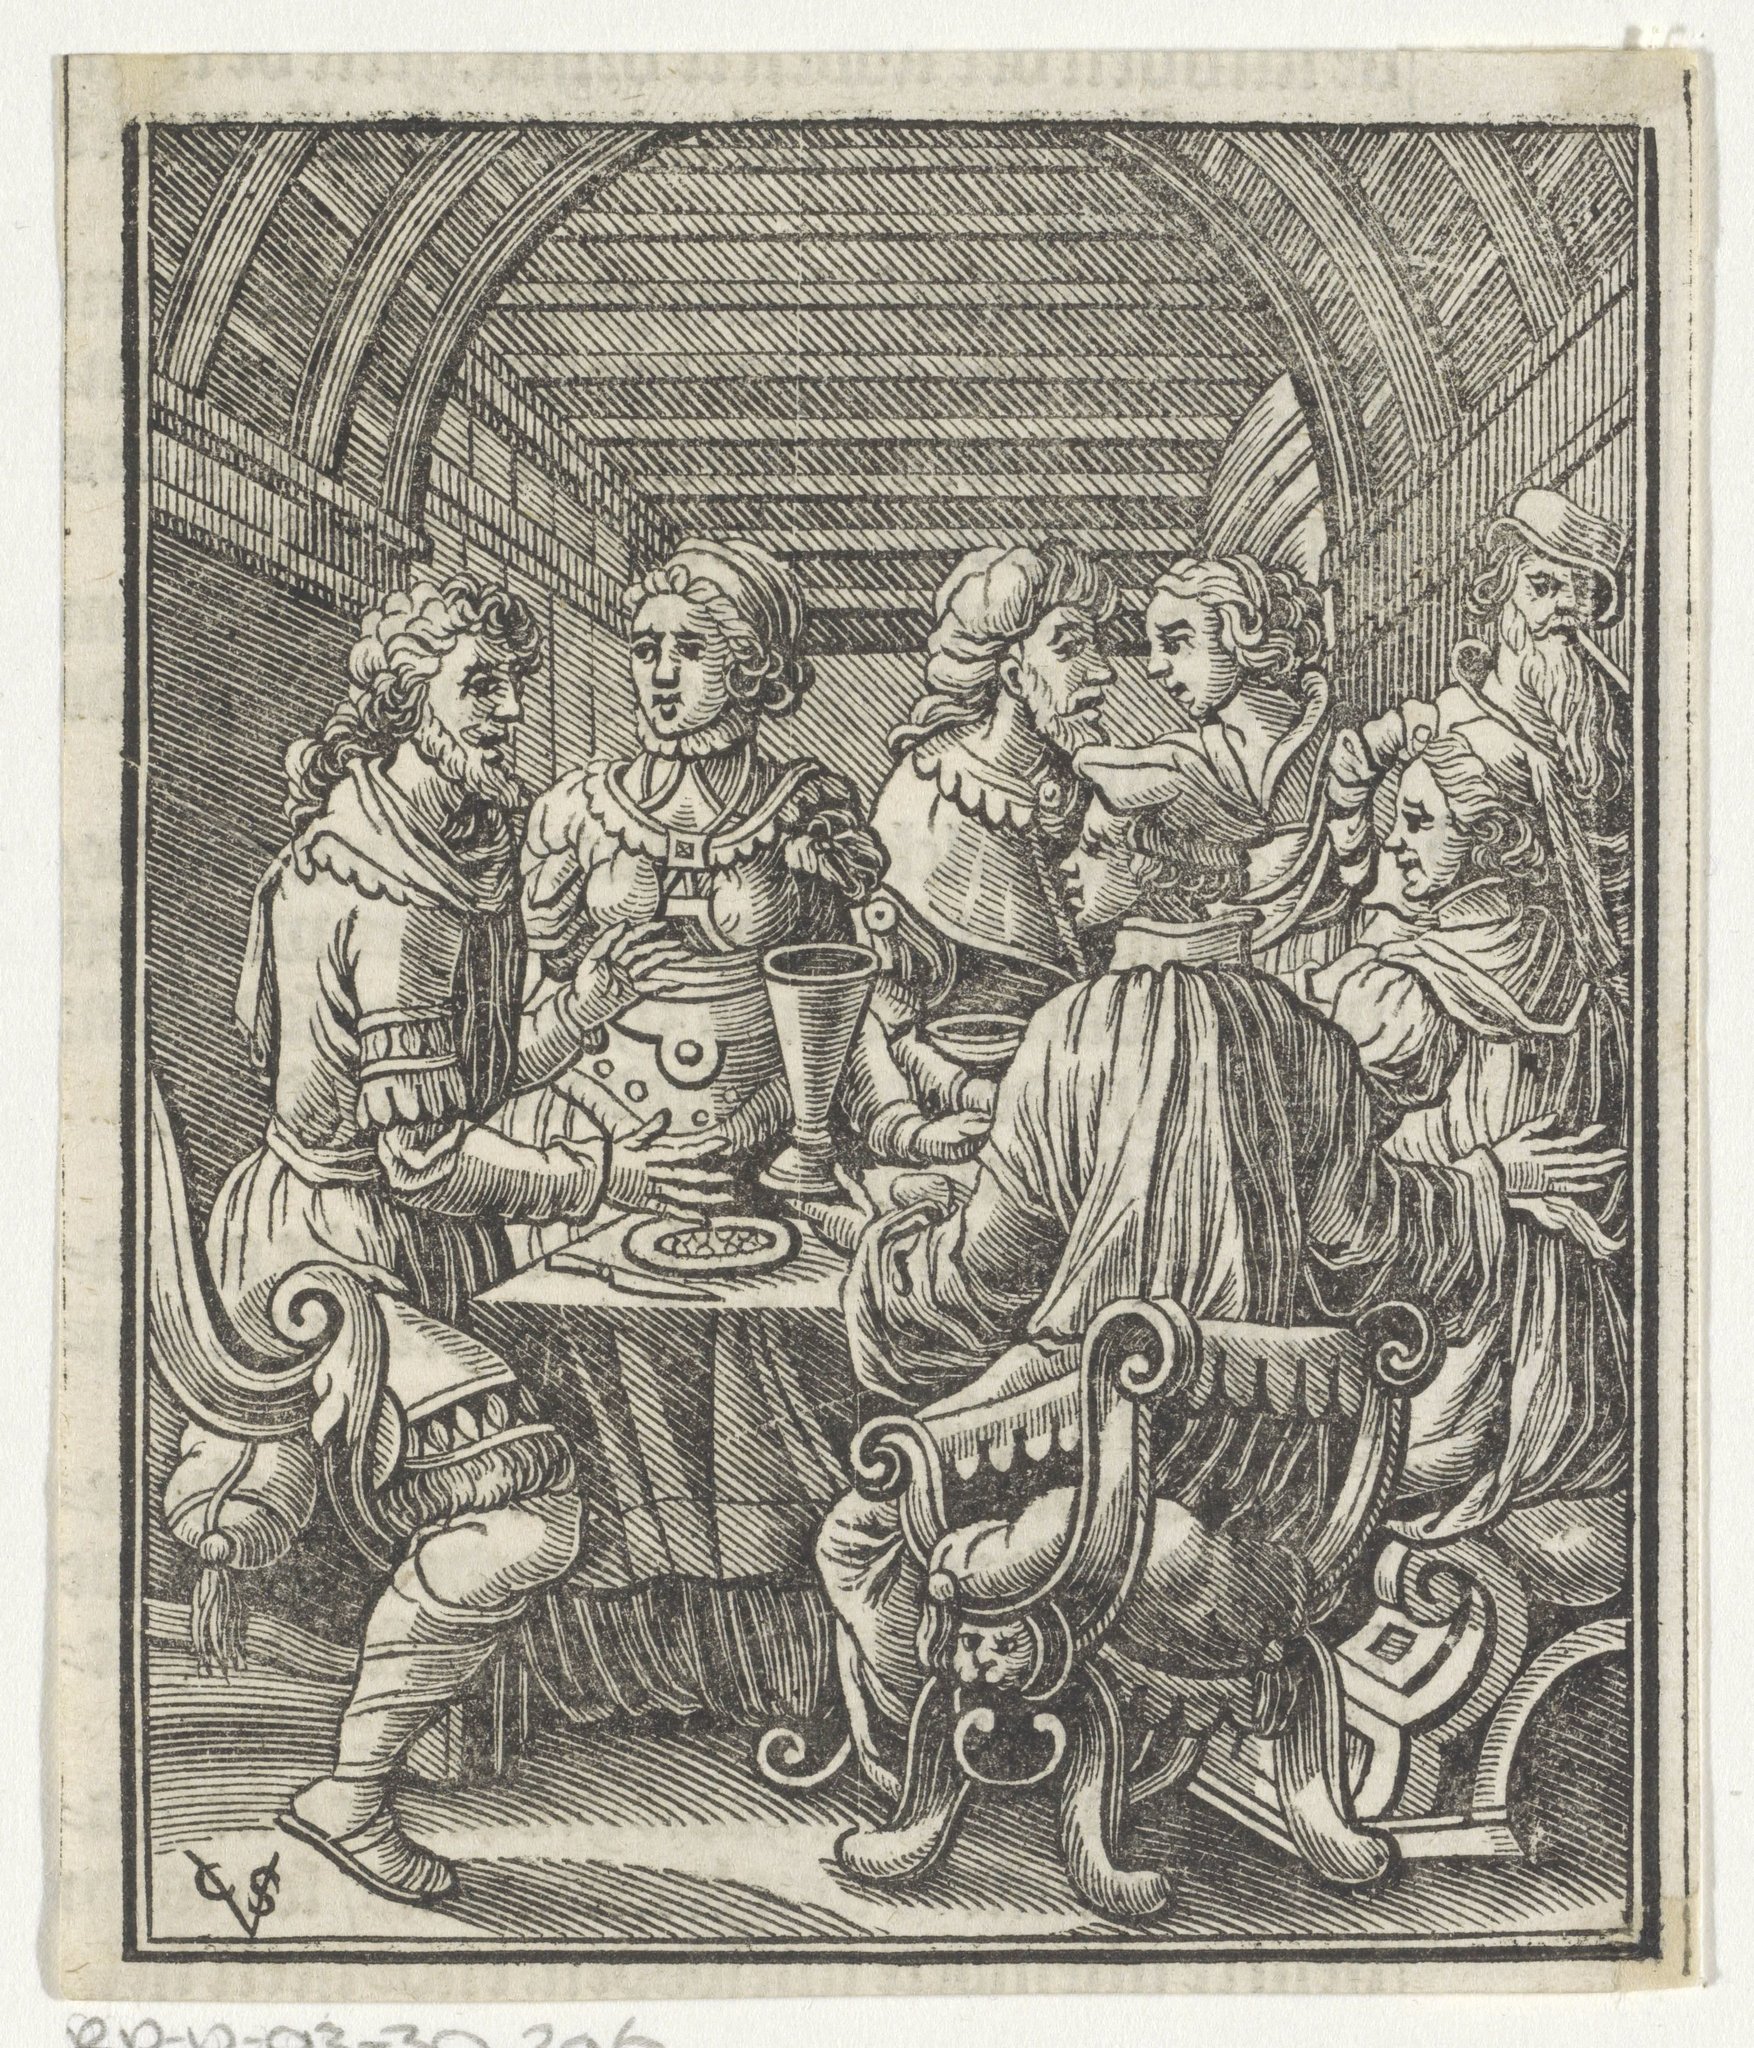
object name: book illustration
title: Gezelschap rondom een tafel met daarop een maaltijd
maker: christoffel van sichem (ii)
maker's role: print maker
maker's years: 1581-1658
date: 1581-1658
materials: paper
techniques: letterpress printing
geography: amsterdam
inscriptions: collector's mark: Lugt 2228